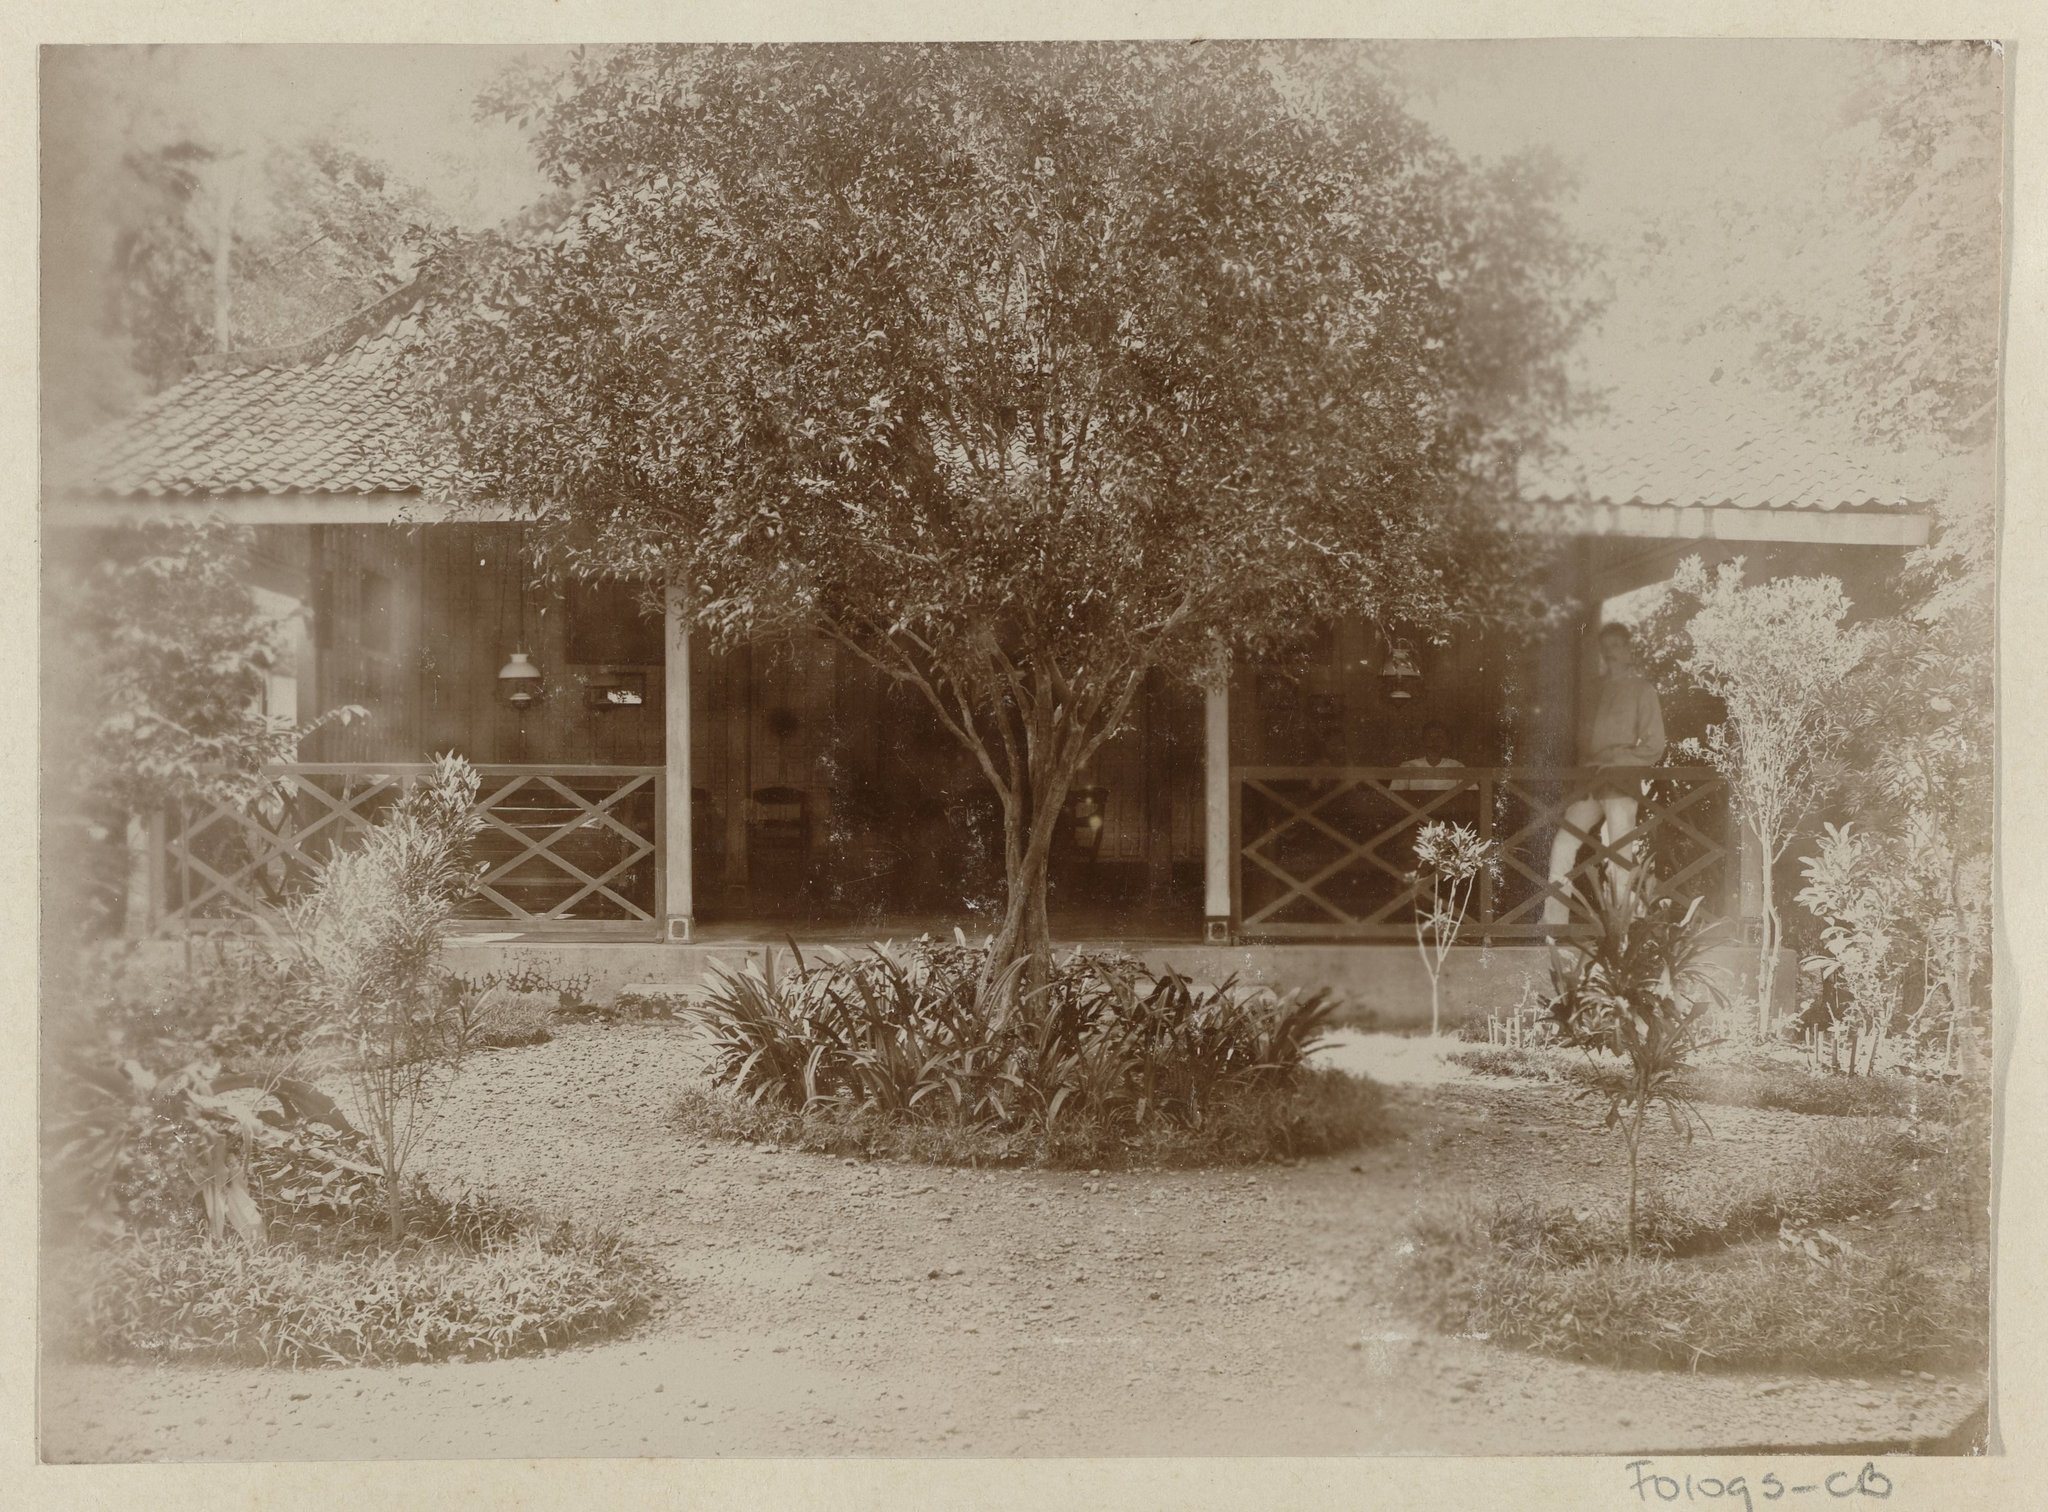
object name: photograph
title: Tuin bij een huis met een veranda in Nederlands-Indië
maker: Anonymous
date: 1895-1905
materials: paper, photographic support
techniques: collodion silver print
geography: dutch east indies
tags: garden, loggia, verandah, porch, dutch east indies, the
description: Onderdeel van Reisalbum met foto's van bezienswaardigheden in Italië, Zwitserland en Nederlands-Indië.